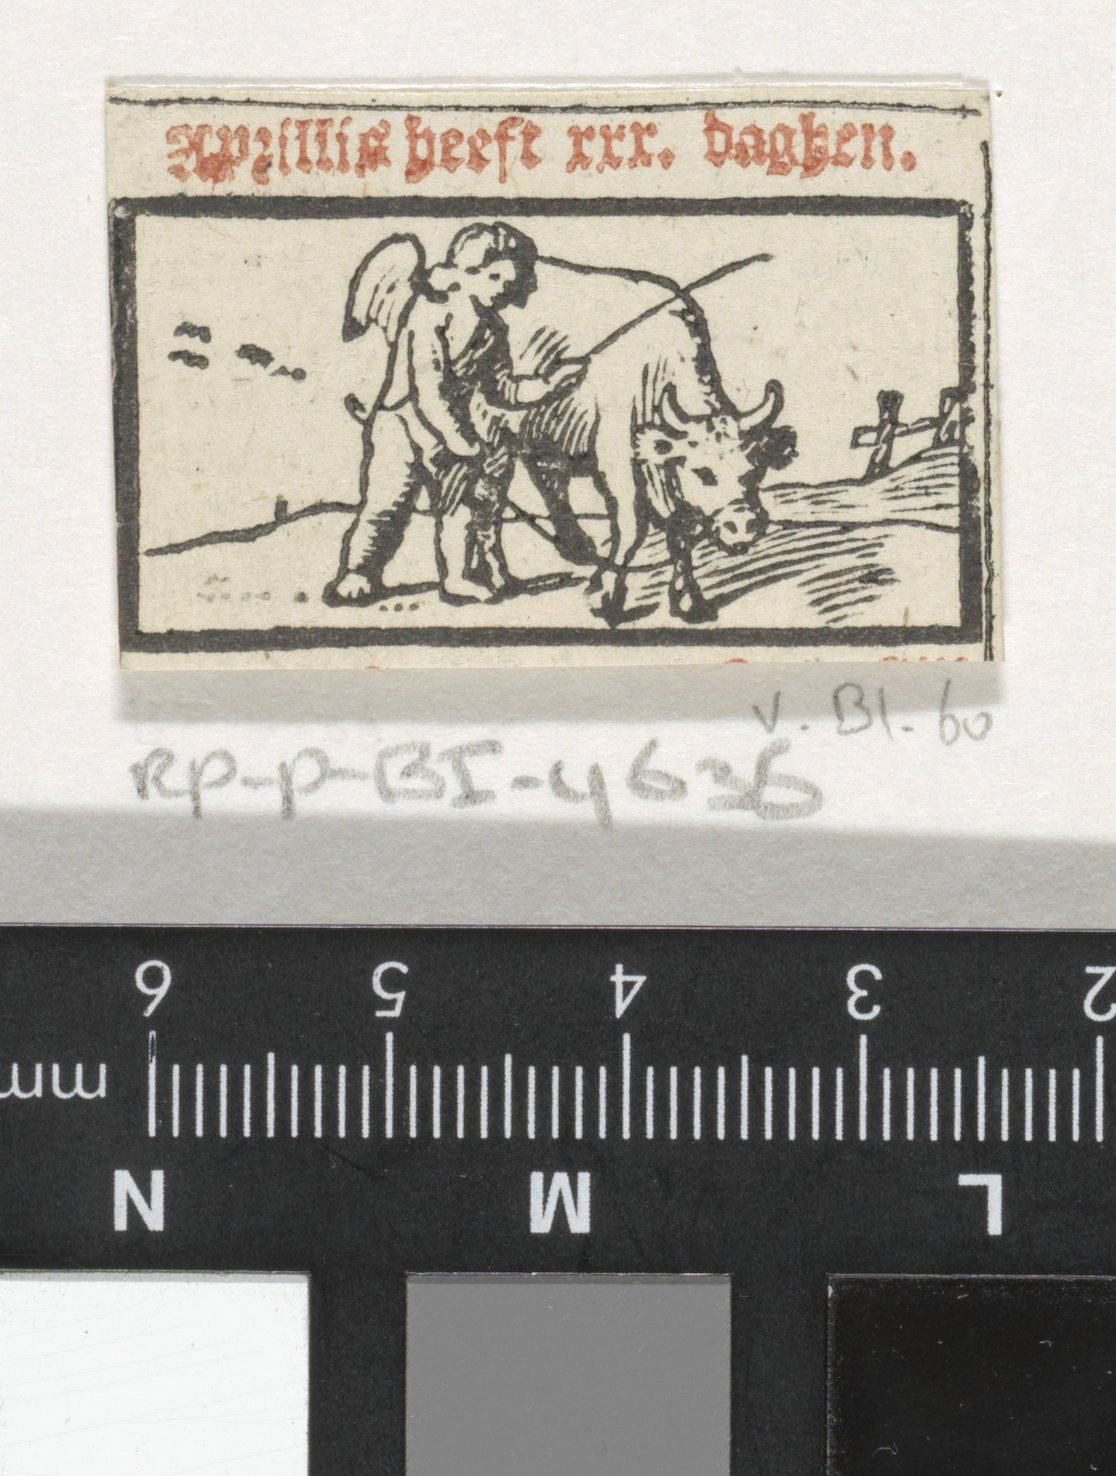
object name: print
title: April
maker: dirck de bray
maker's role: draughtsman, painter, print maker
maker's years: 1625-1694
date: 1635-1694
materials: paper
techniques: letterpress printing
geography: netherlands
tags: april and its 'labours' (+ with taurus (april))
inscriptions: collector's mark: Lugt 2228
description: Een putto ment een stier. In de bovenmarge een regel Nederlandse tekst.